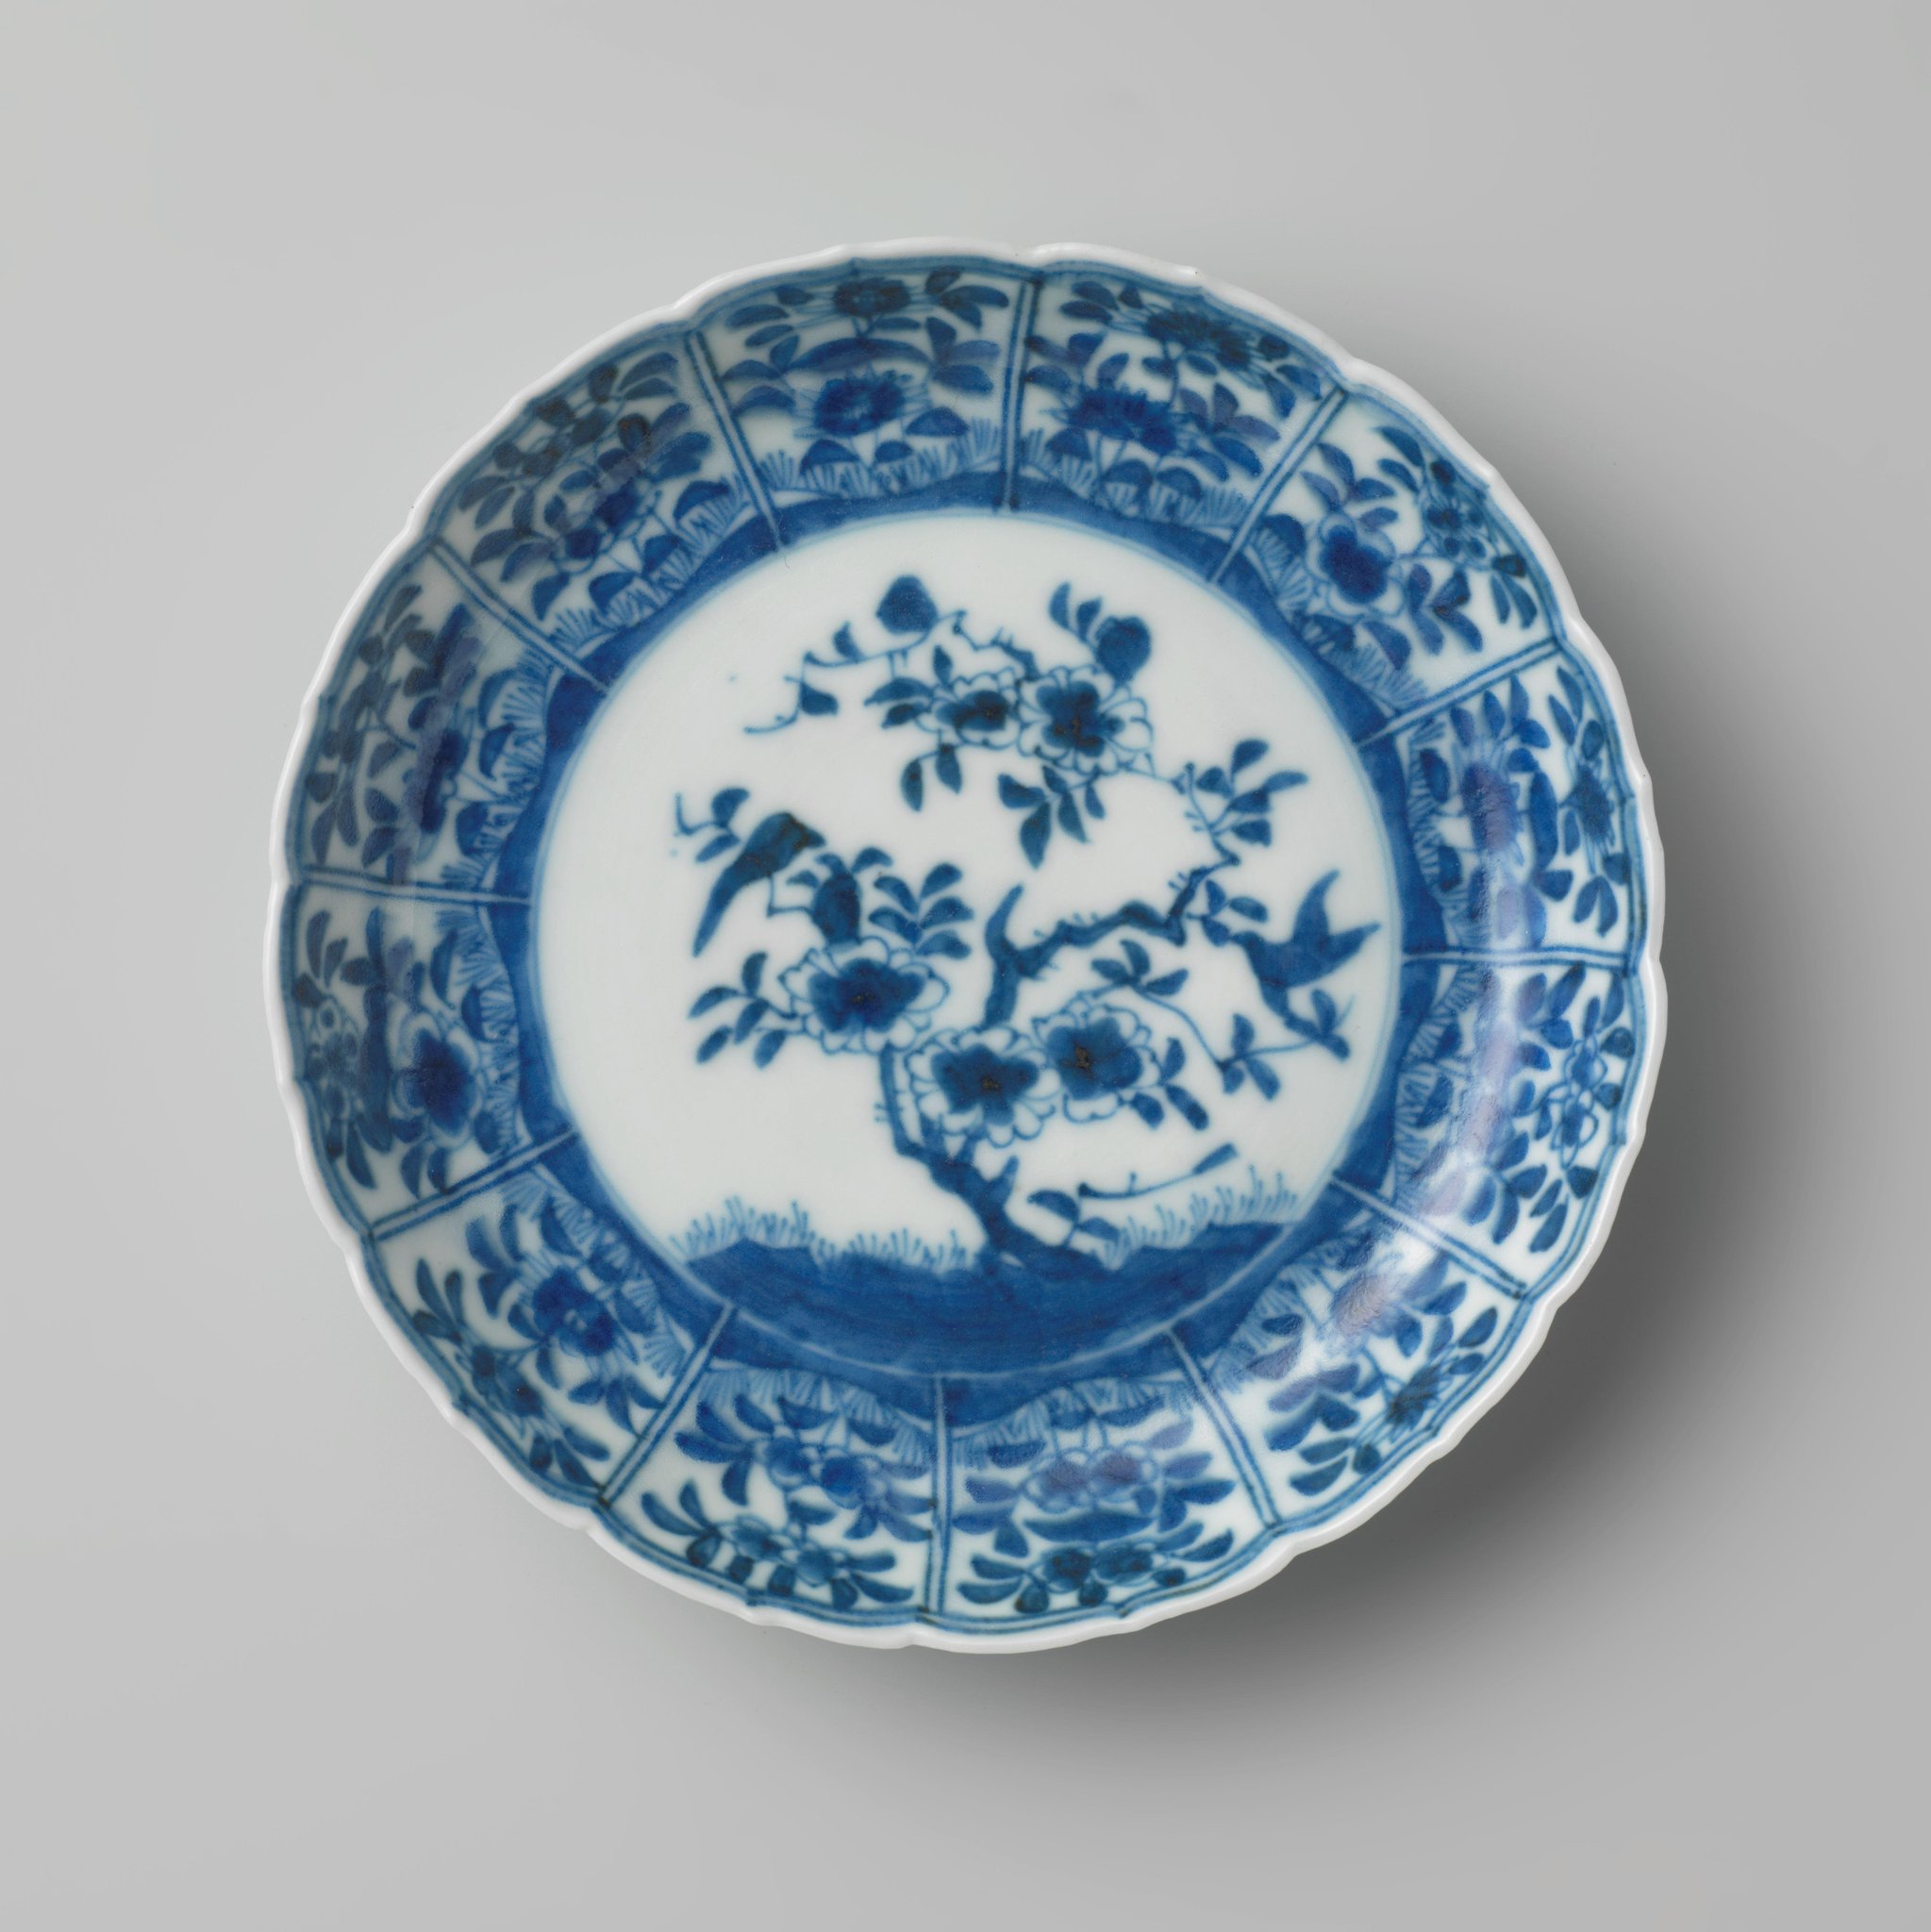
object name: platter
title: Saucer with flowering plants and two birds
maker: Anonymous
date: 1700-1725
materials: cobalt, glaze, paint, porcelain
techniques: firing, turning, vitrification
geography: china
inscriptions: mark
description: Schotel van porselein met accoladevormige rand, beschilderd in onderglazuur blauw. Op het plat een bloeiende plant met een vliegende vogel en een vogel op een tak. De wand is gemodelleerd in twaalf vakken, elk gevuld met een bloeiende plant. De buitenwand met drie cameliatakken. Gemerkt op de onderzijde met een ongeïdentificeerd zes-karaktermerk in een dubbele cirkel. Blauw-wit.